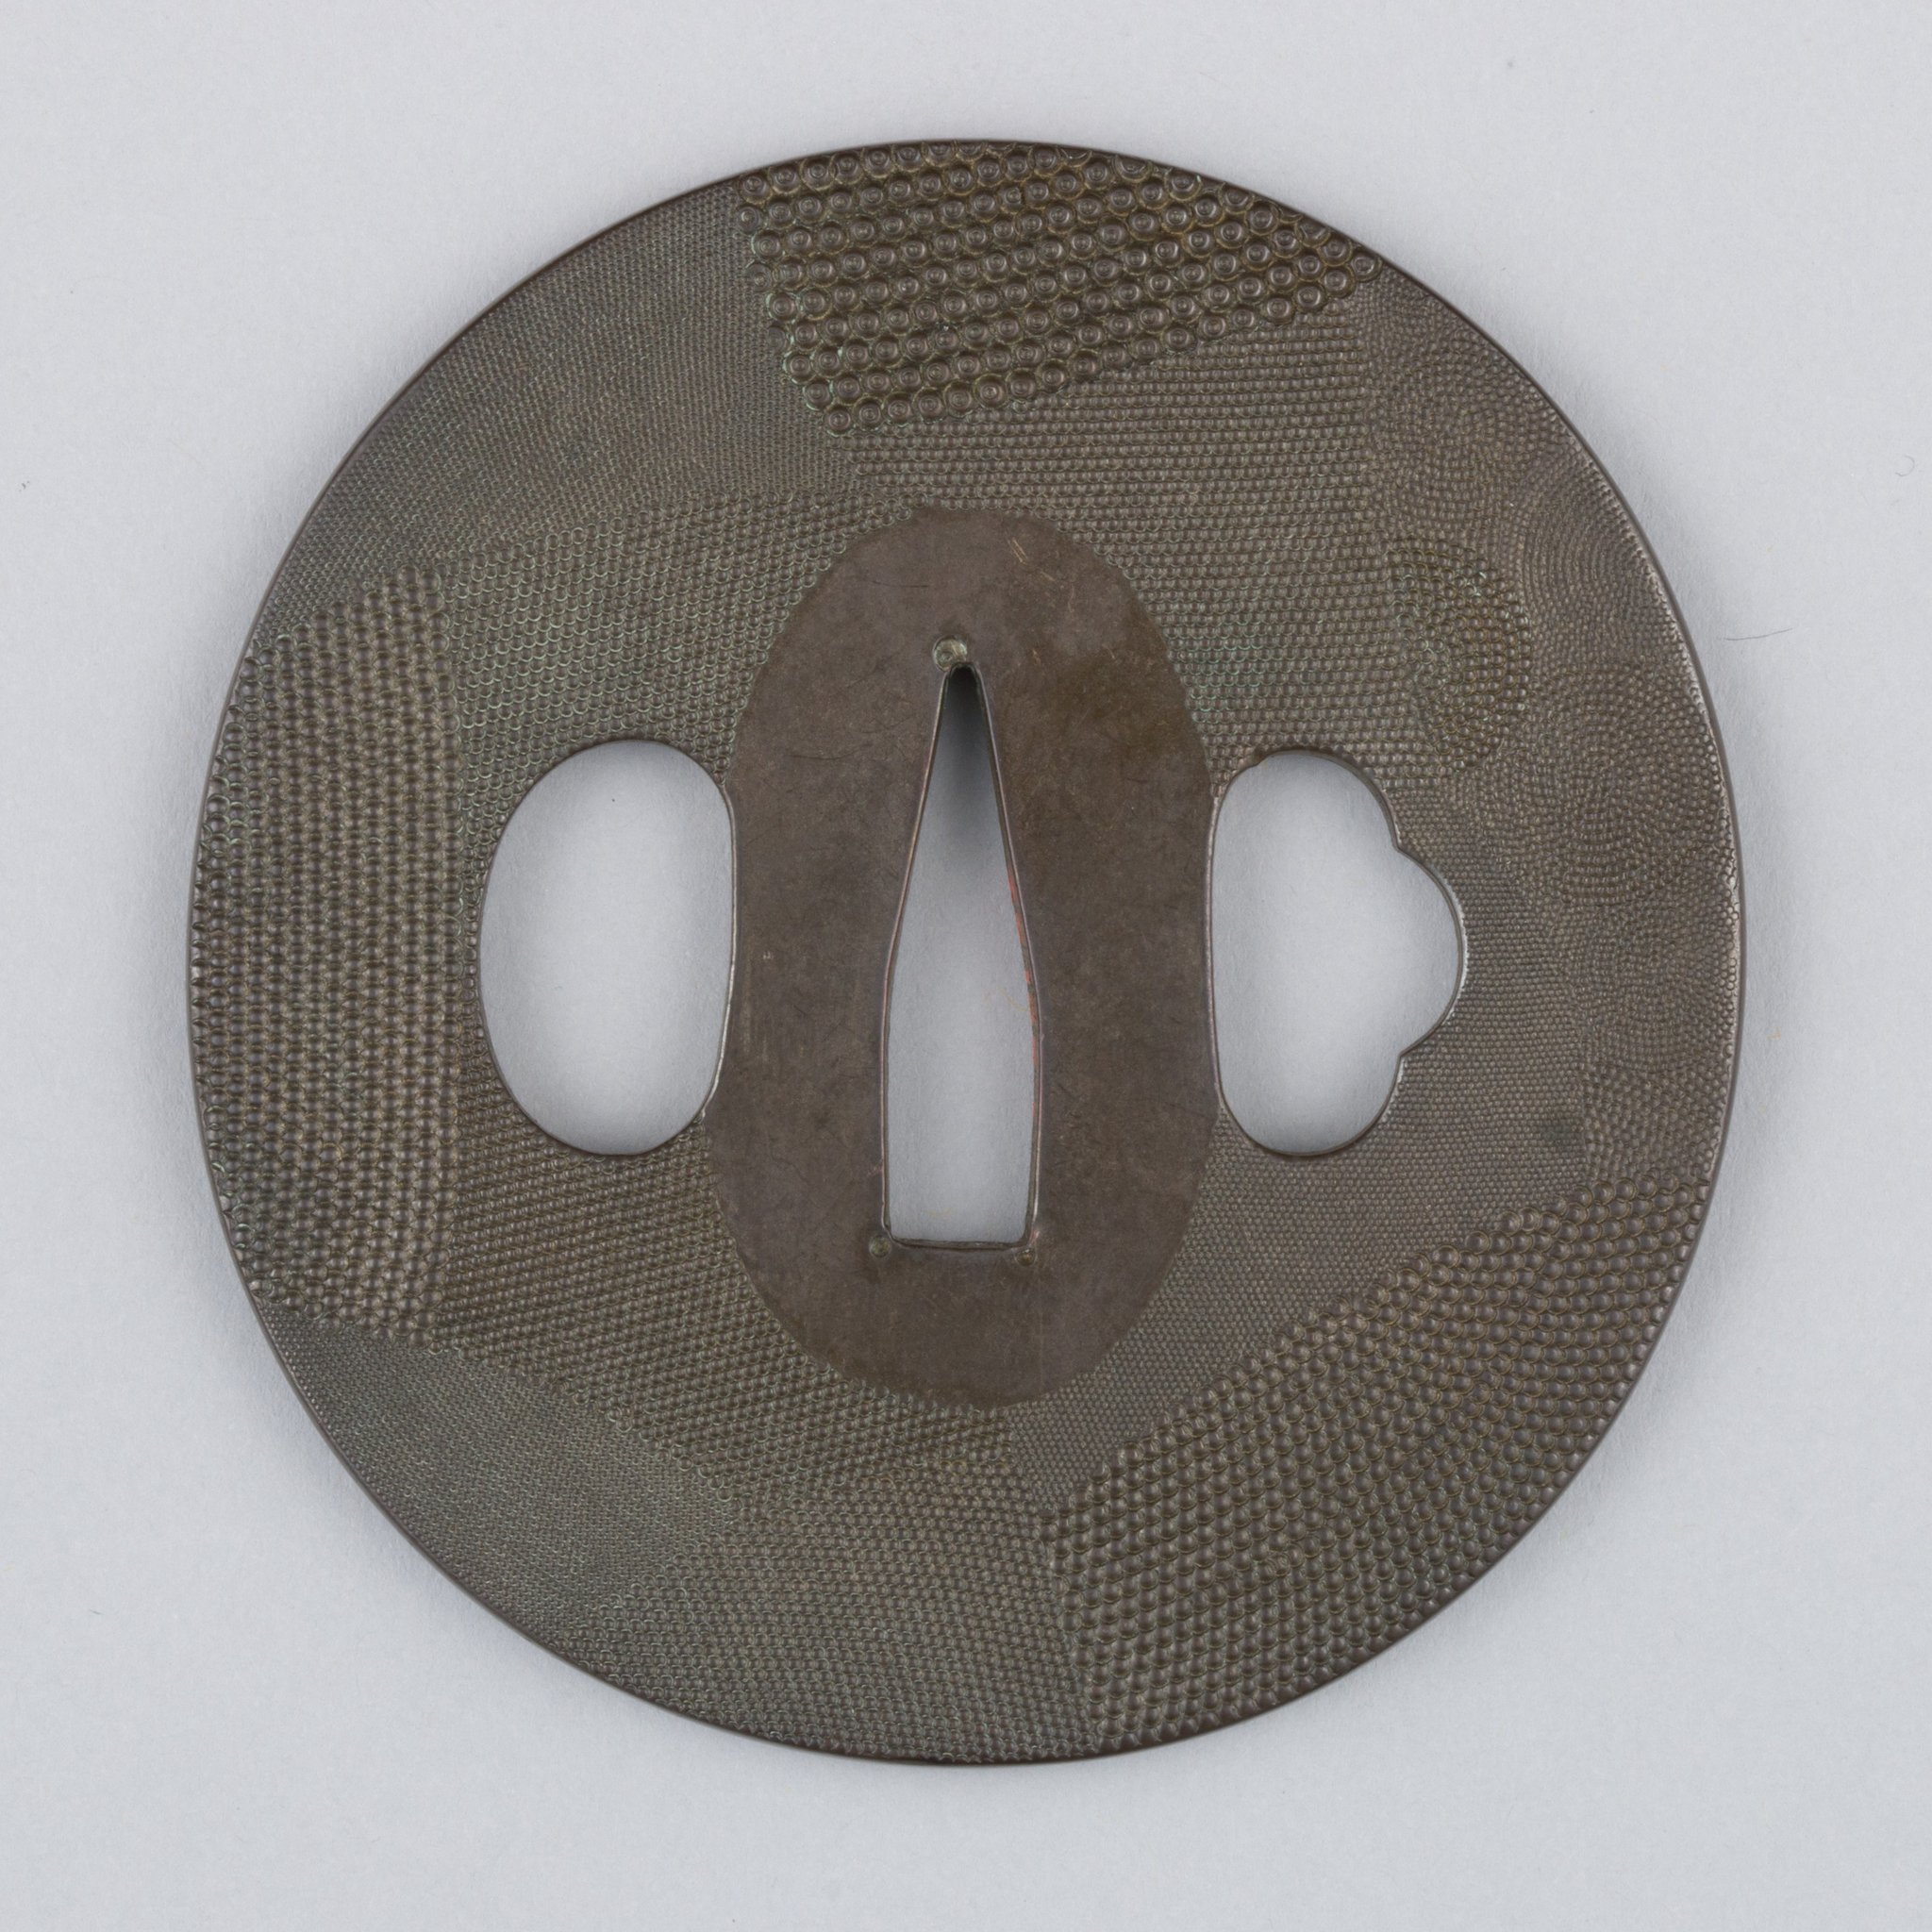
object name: sword guard tsuba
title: Sword Guard (Tsuba)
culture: japanese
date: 1701-1800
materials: copper, silver alloy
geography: japan